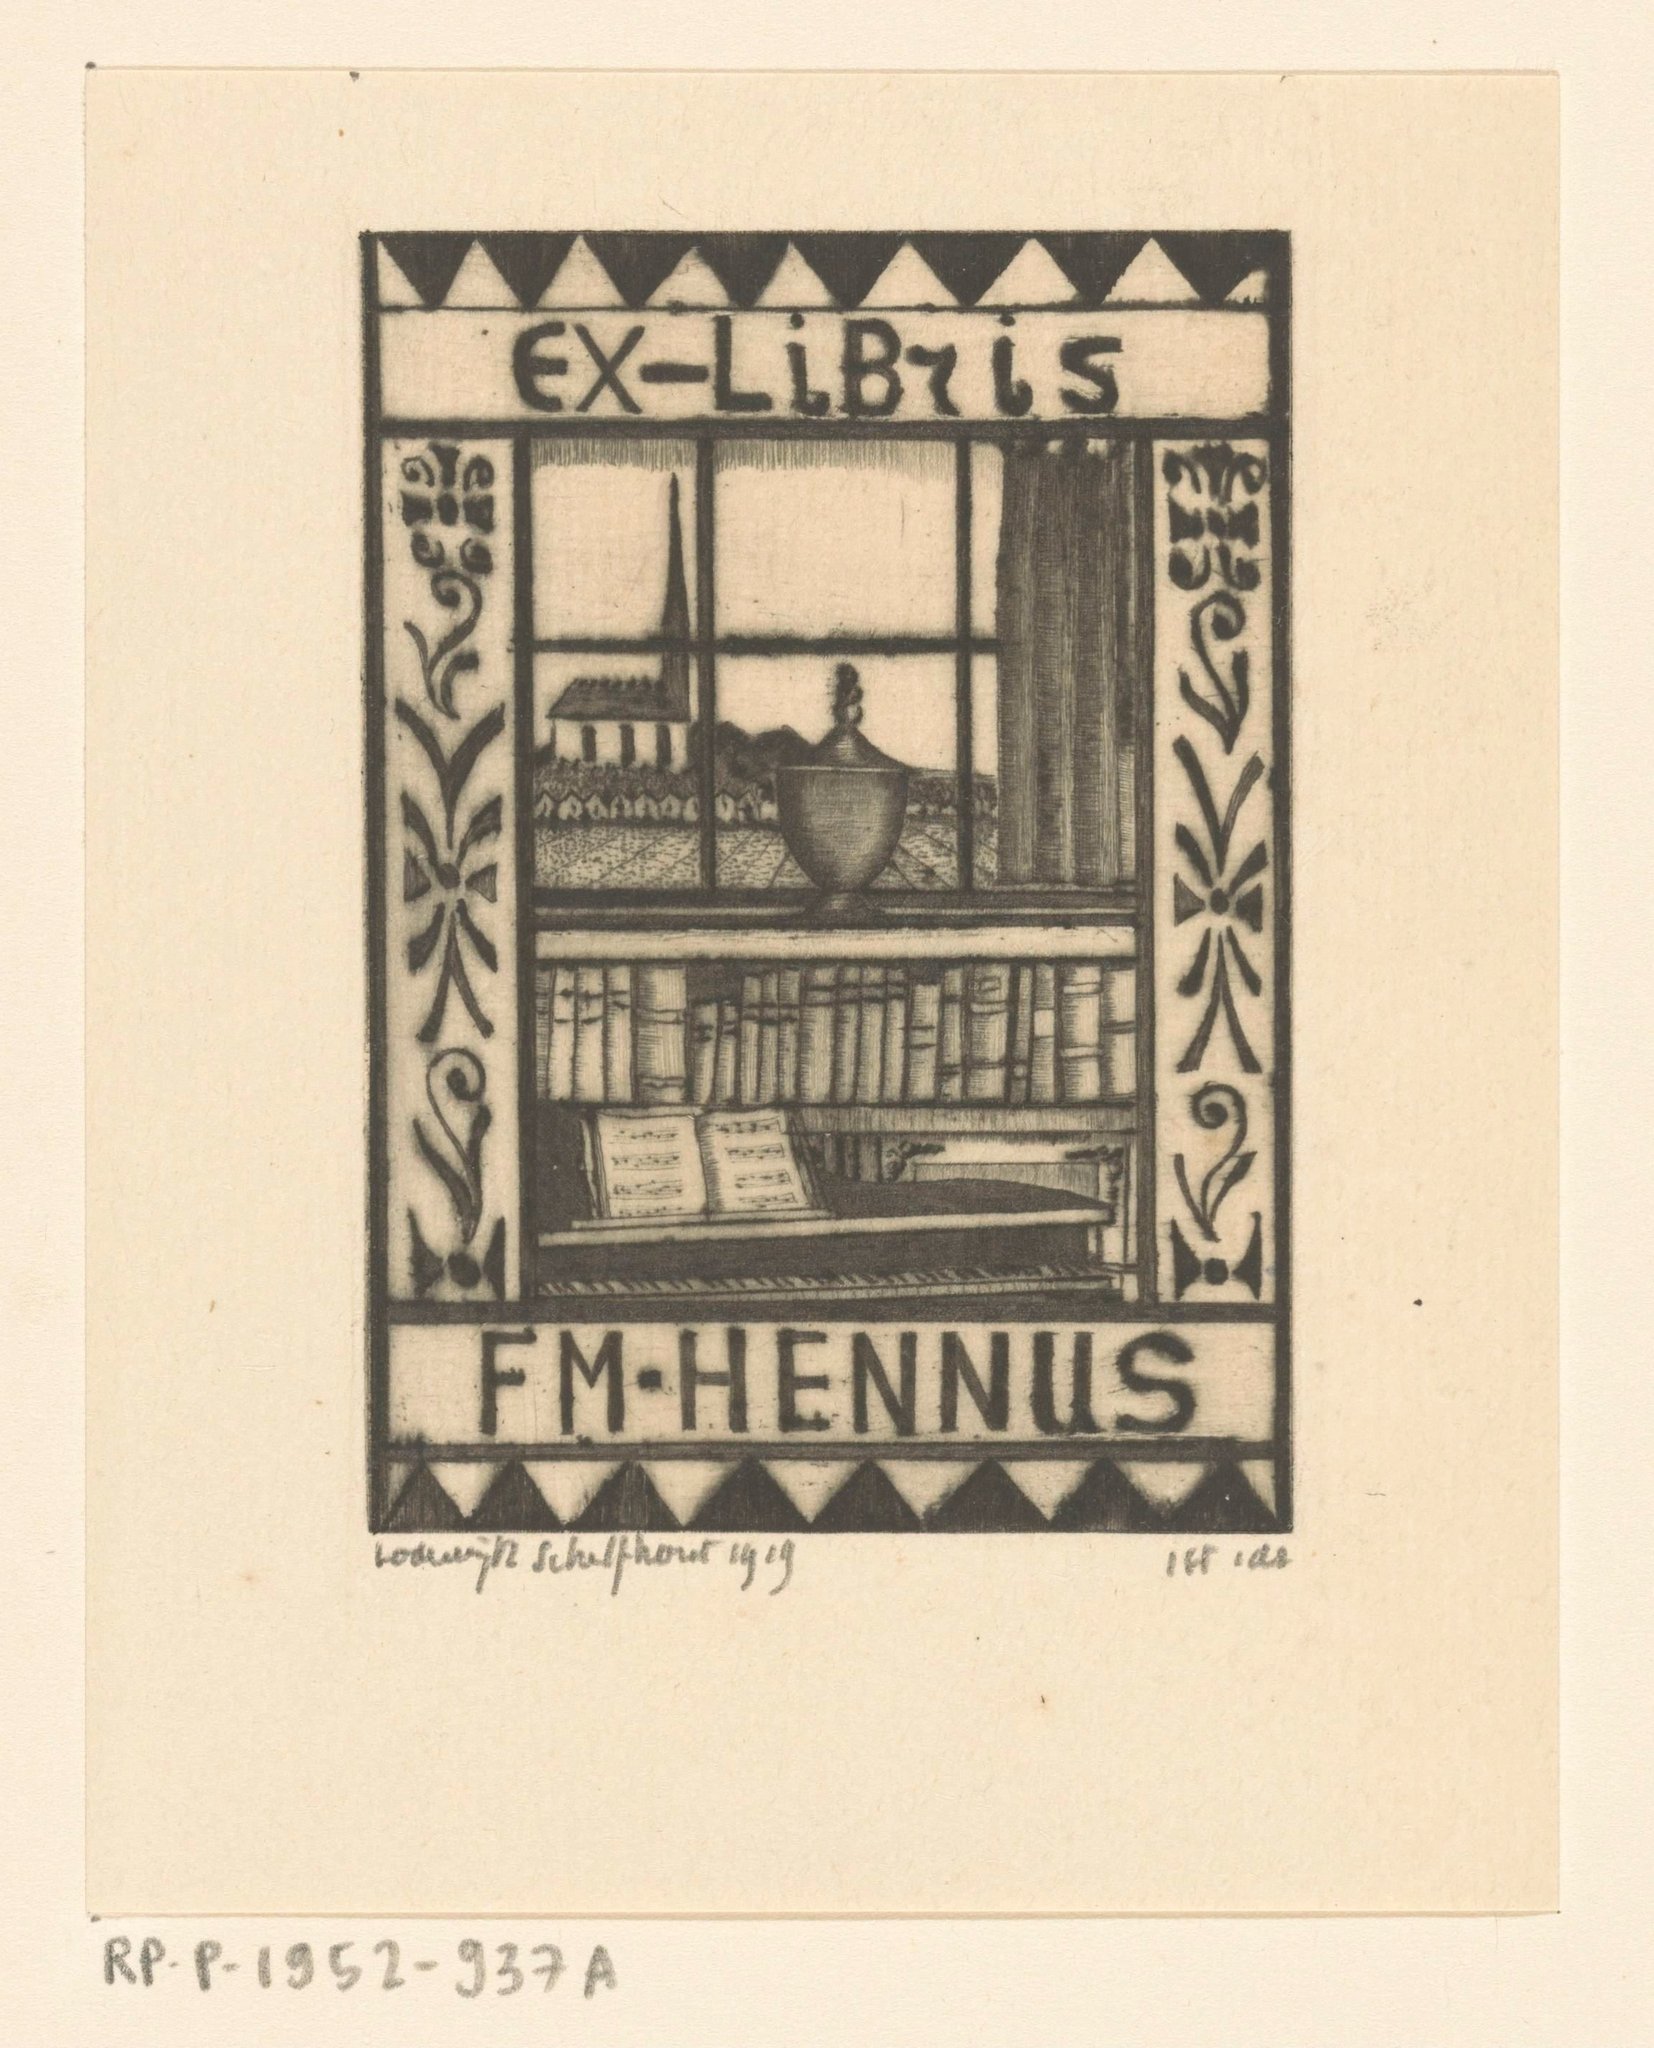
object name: print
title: Ex libris van Michiel Frederik Hennus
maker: lodewijk schelfhout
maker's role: draughtsman, print maker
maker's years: 1881-1943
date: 1919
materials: paper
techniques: drypoint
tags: michiel frederik hennus, church (exterior), view through a window from the inside, book, pianoforte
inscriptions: collector's mark: Lugt 2228, collector's mark: Lugt 2760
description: Een interieur met een piano en een boekenplank. Door een venster zicht op een kerk.